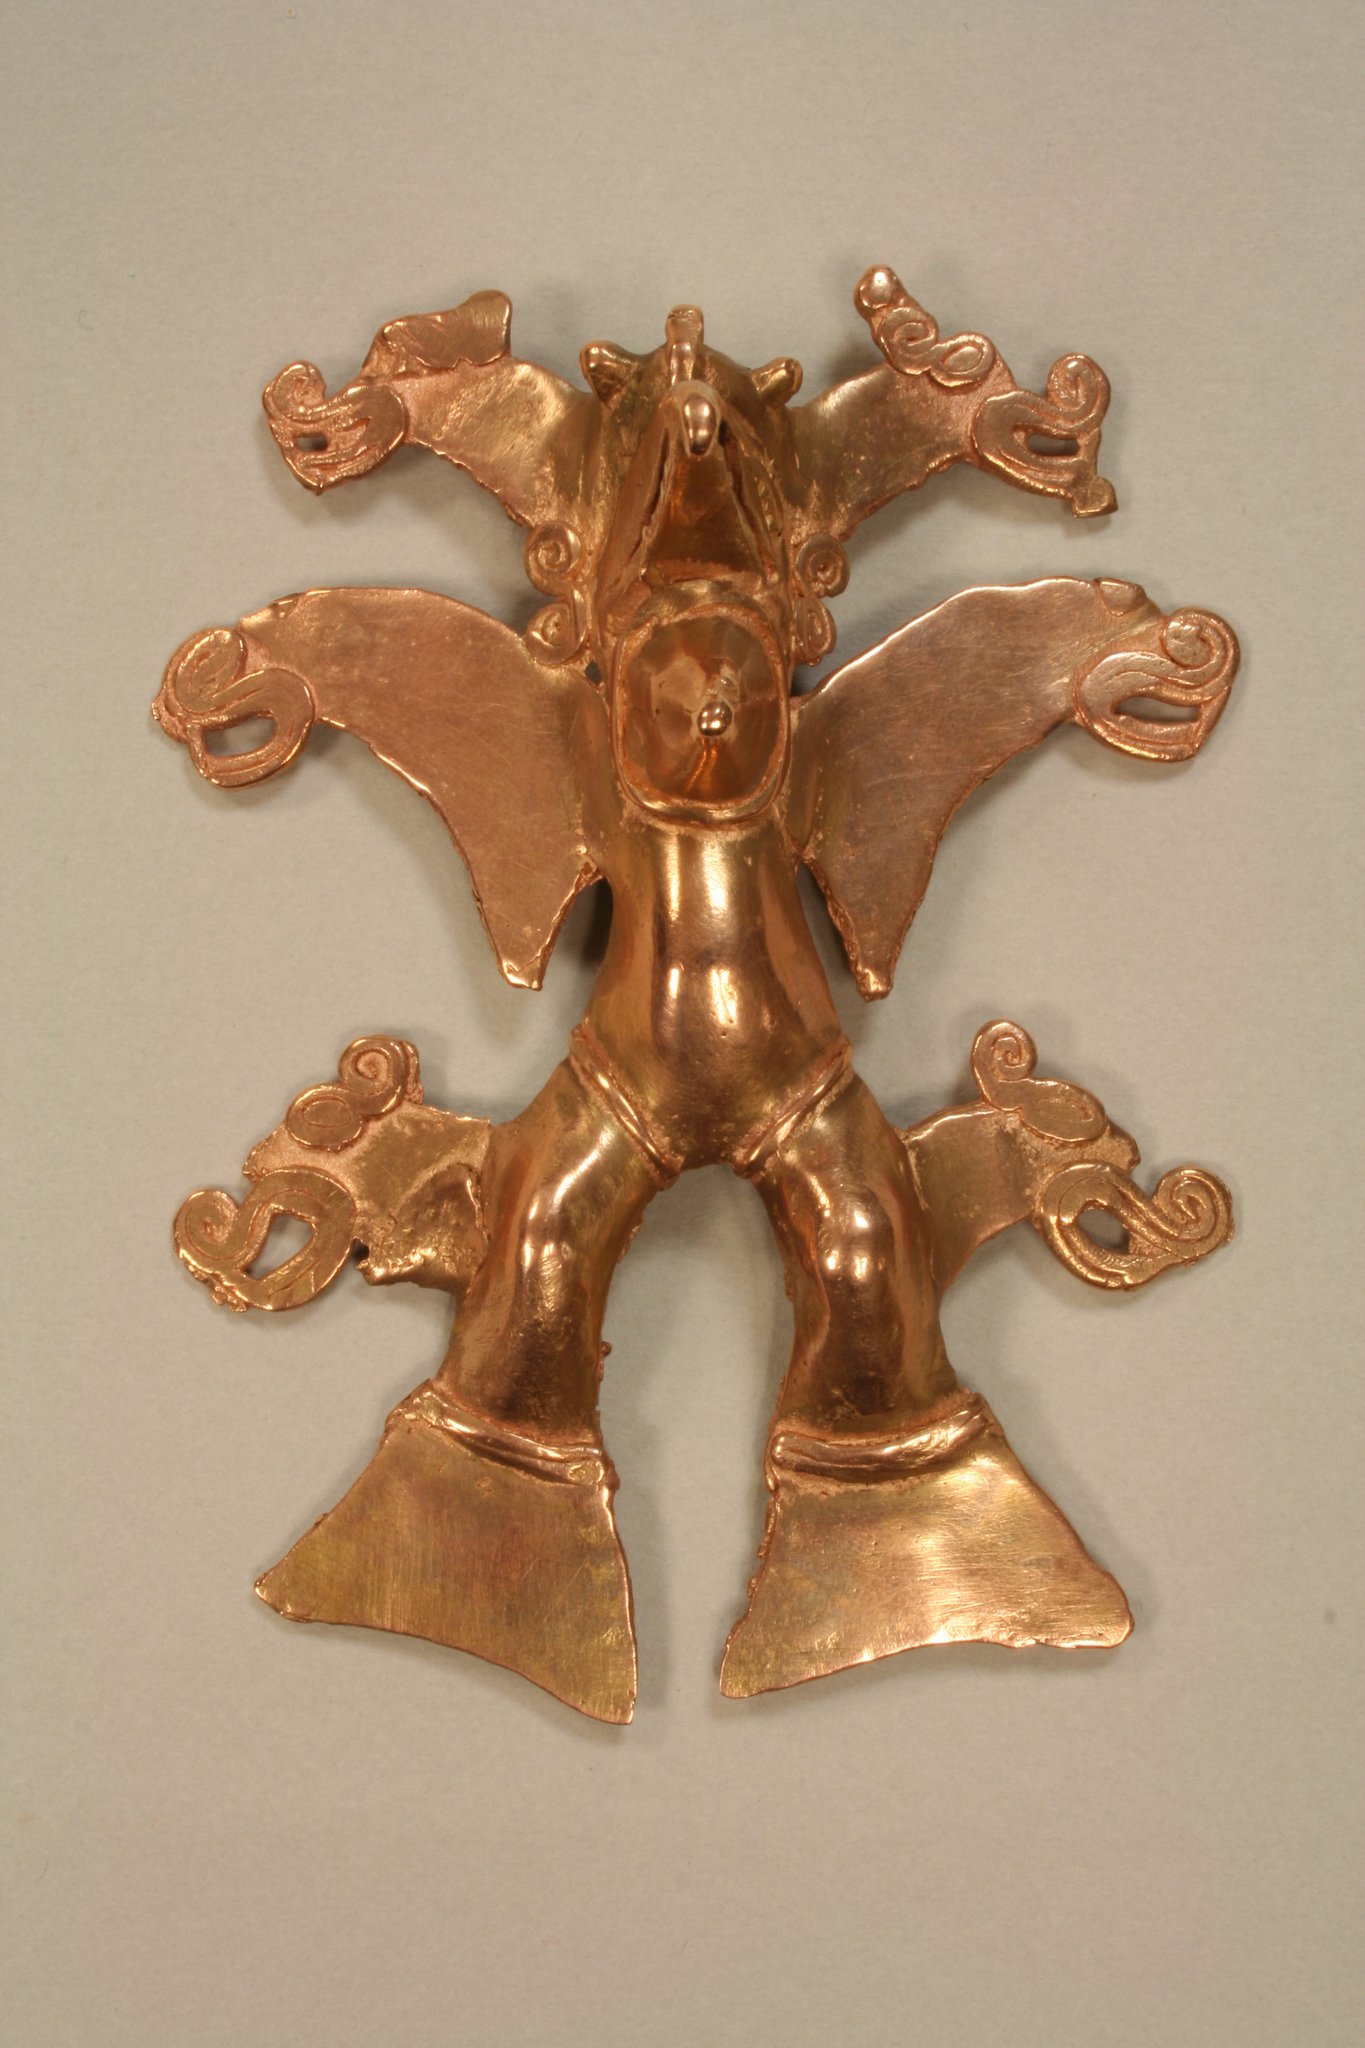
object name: pendant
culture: chiriqui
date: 1001-1600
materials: gold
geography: costa rica